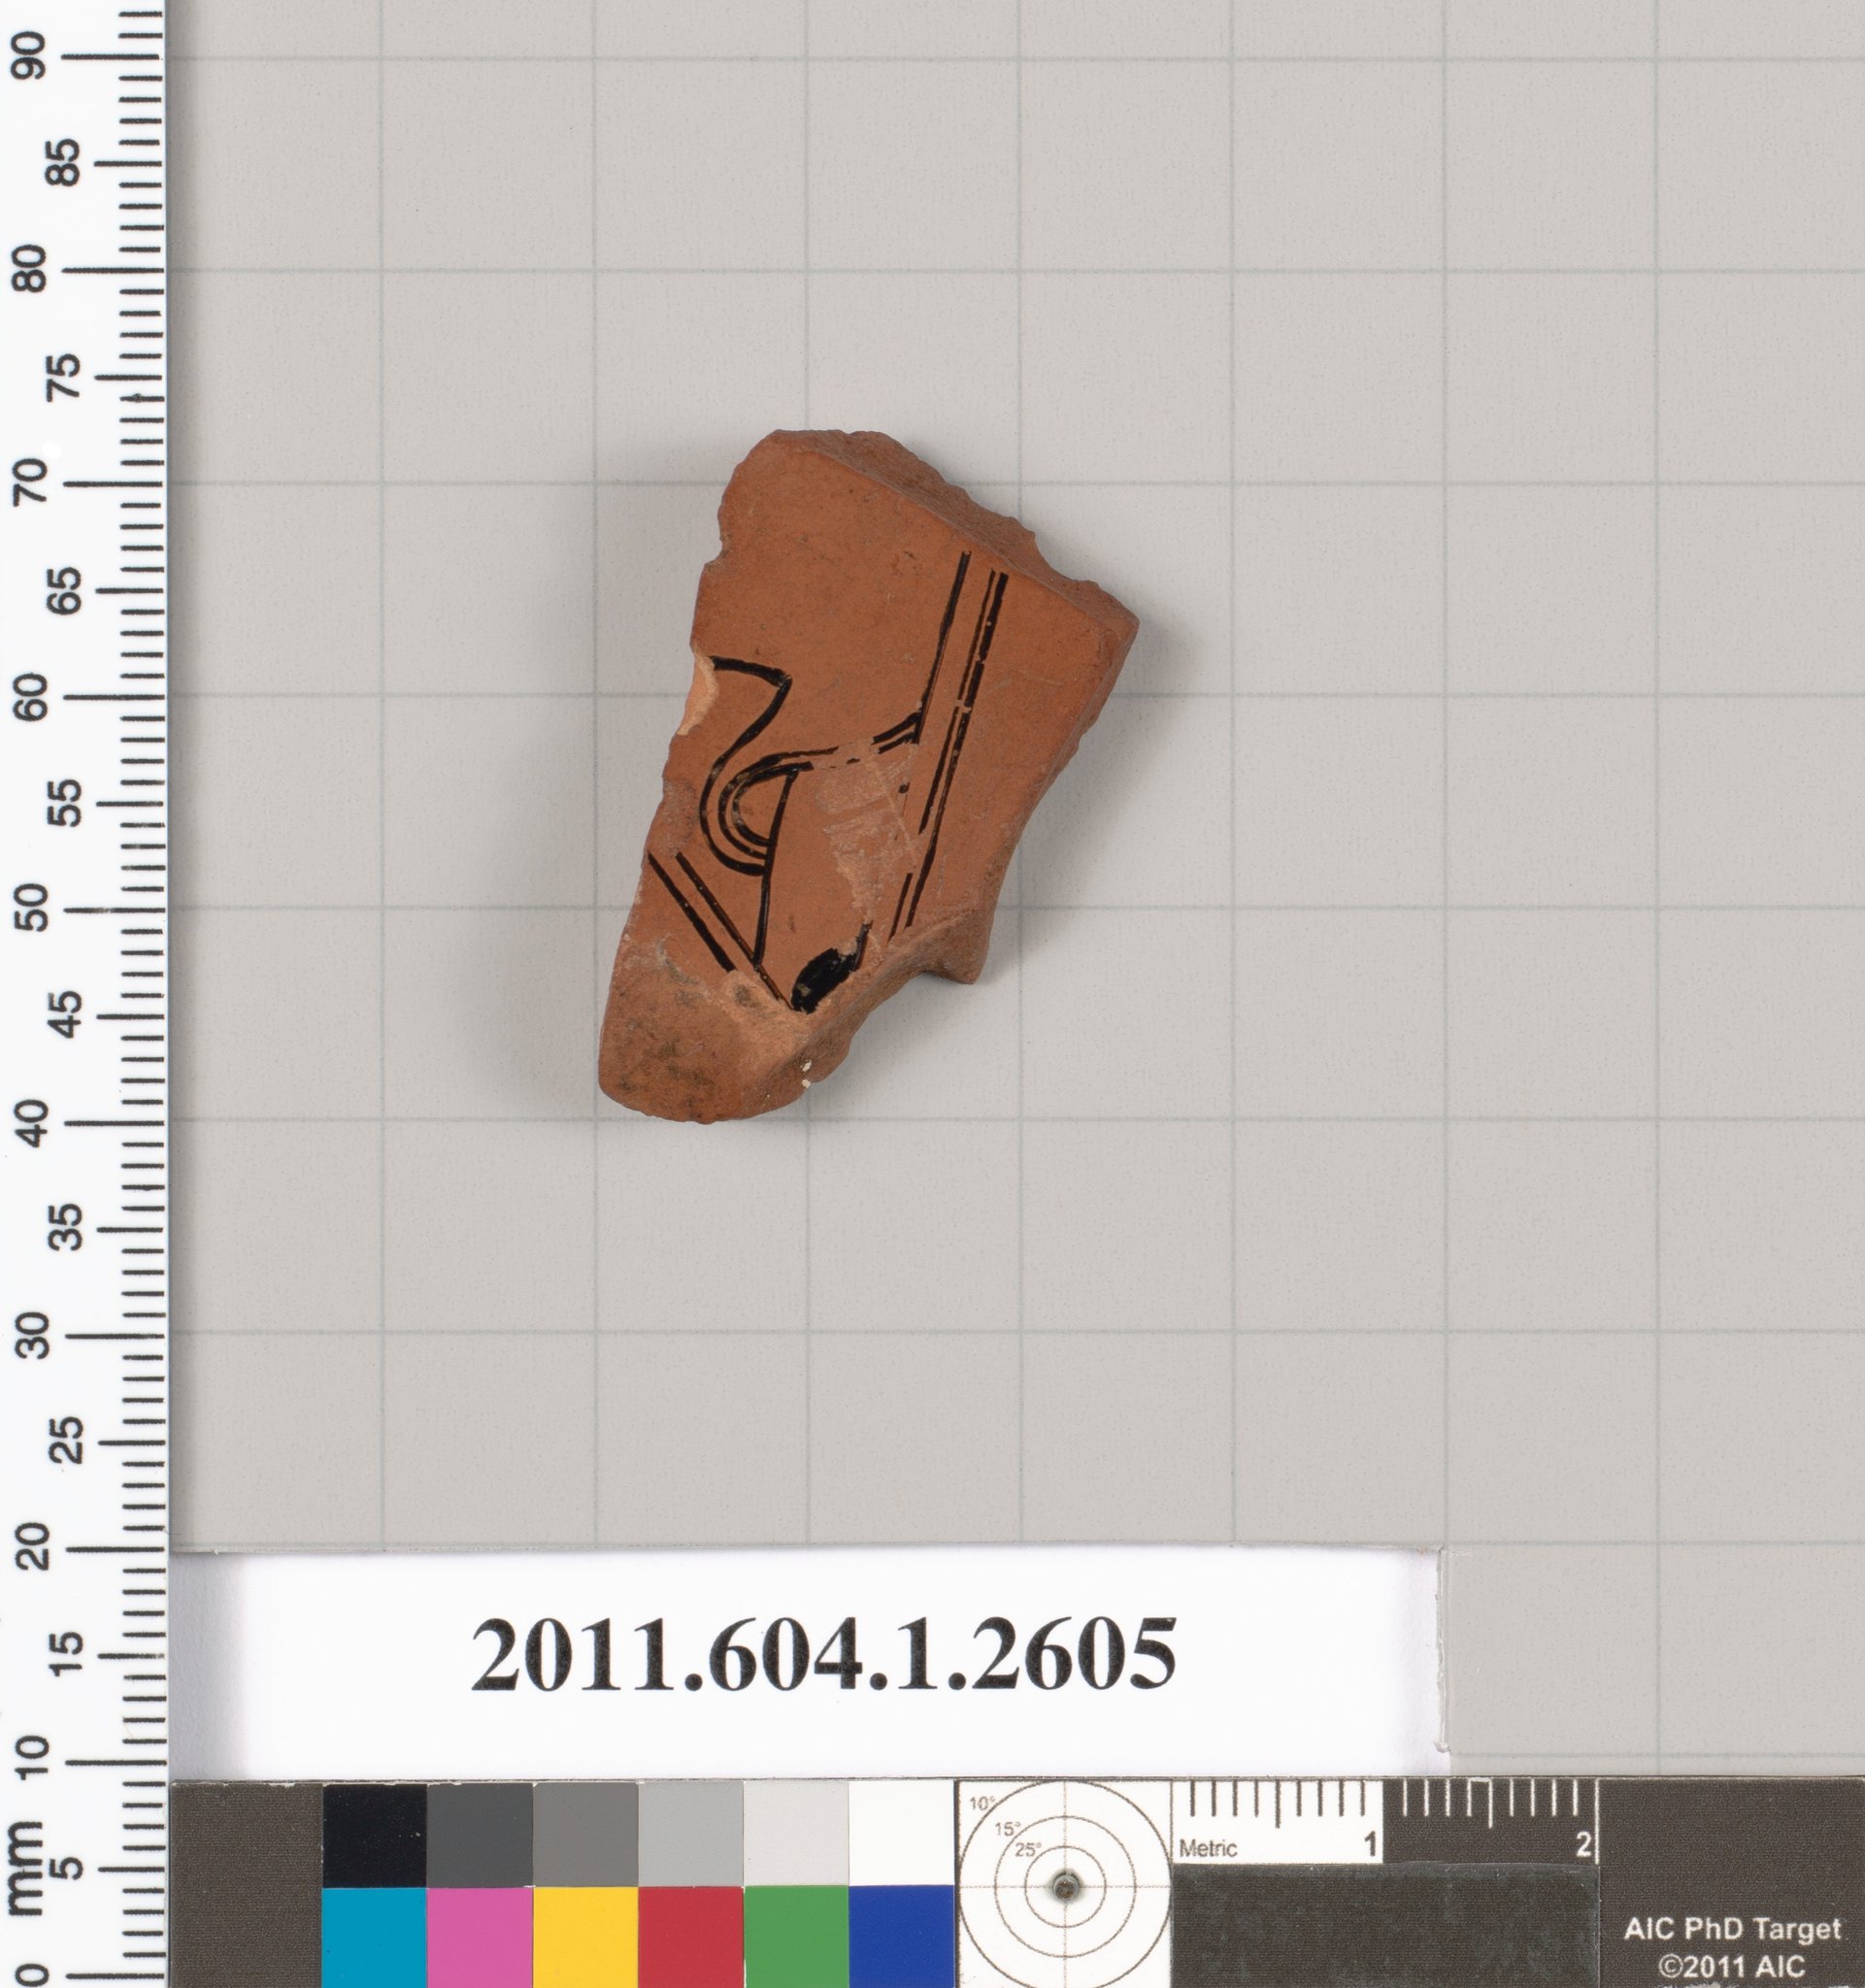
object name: kylix fragment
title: Terracotta fragment of a kylix (drinking cup)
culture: greek, attic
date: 490-480 BCE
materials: terracotta